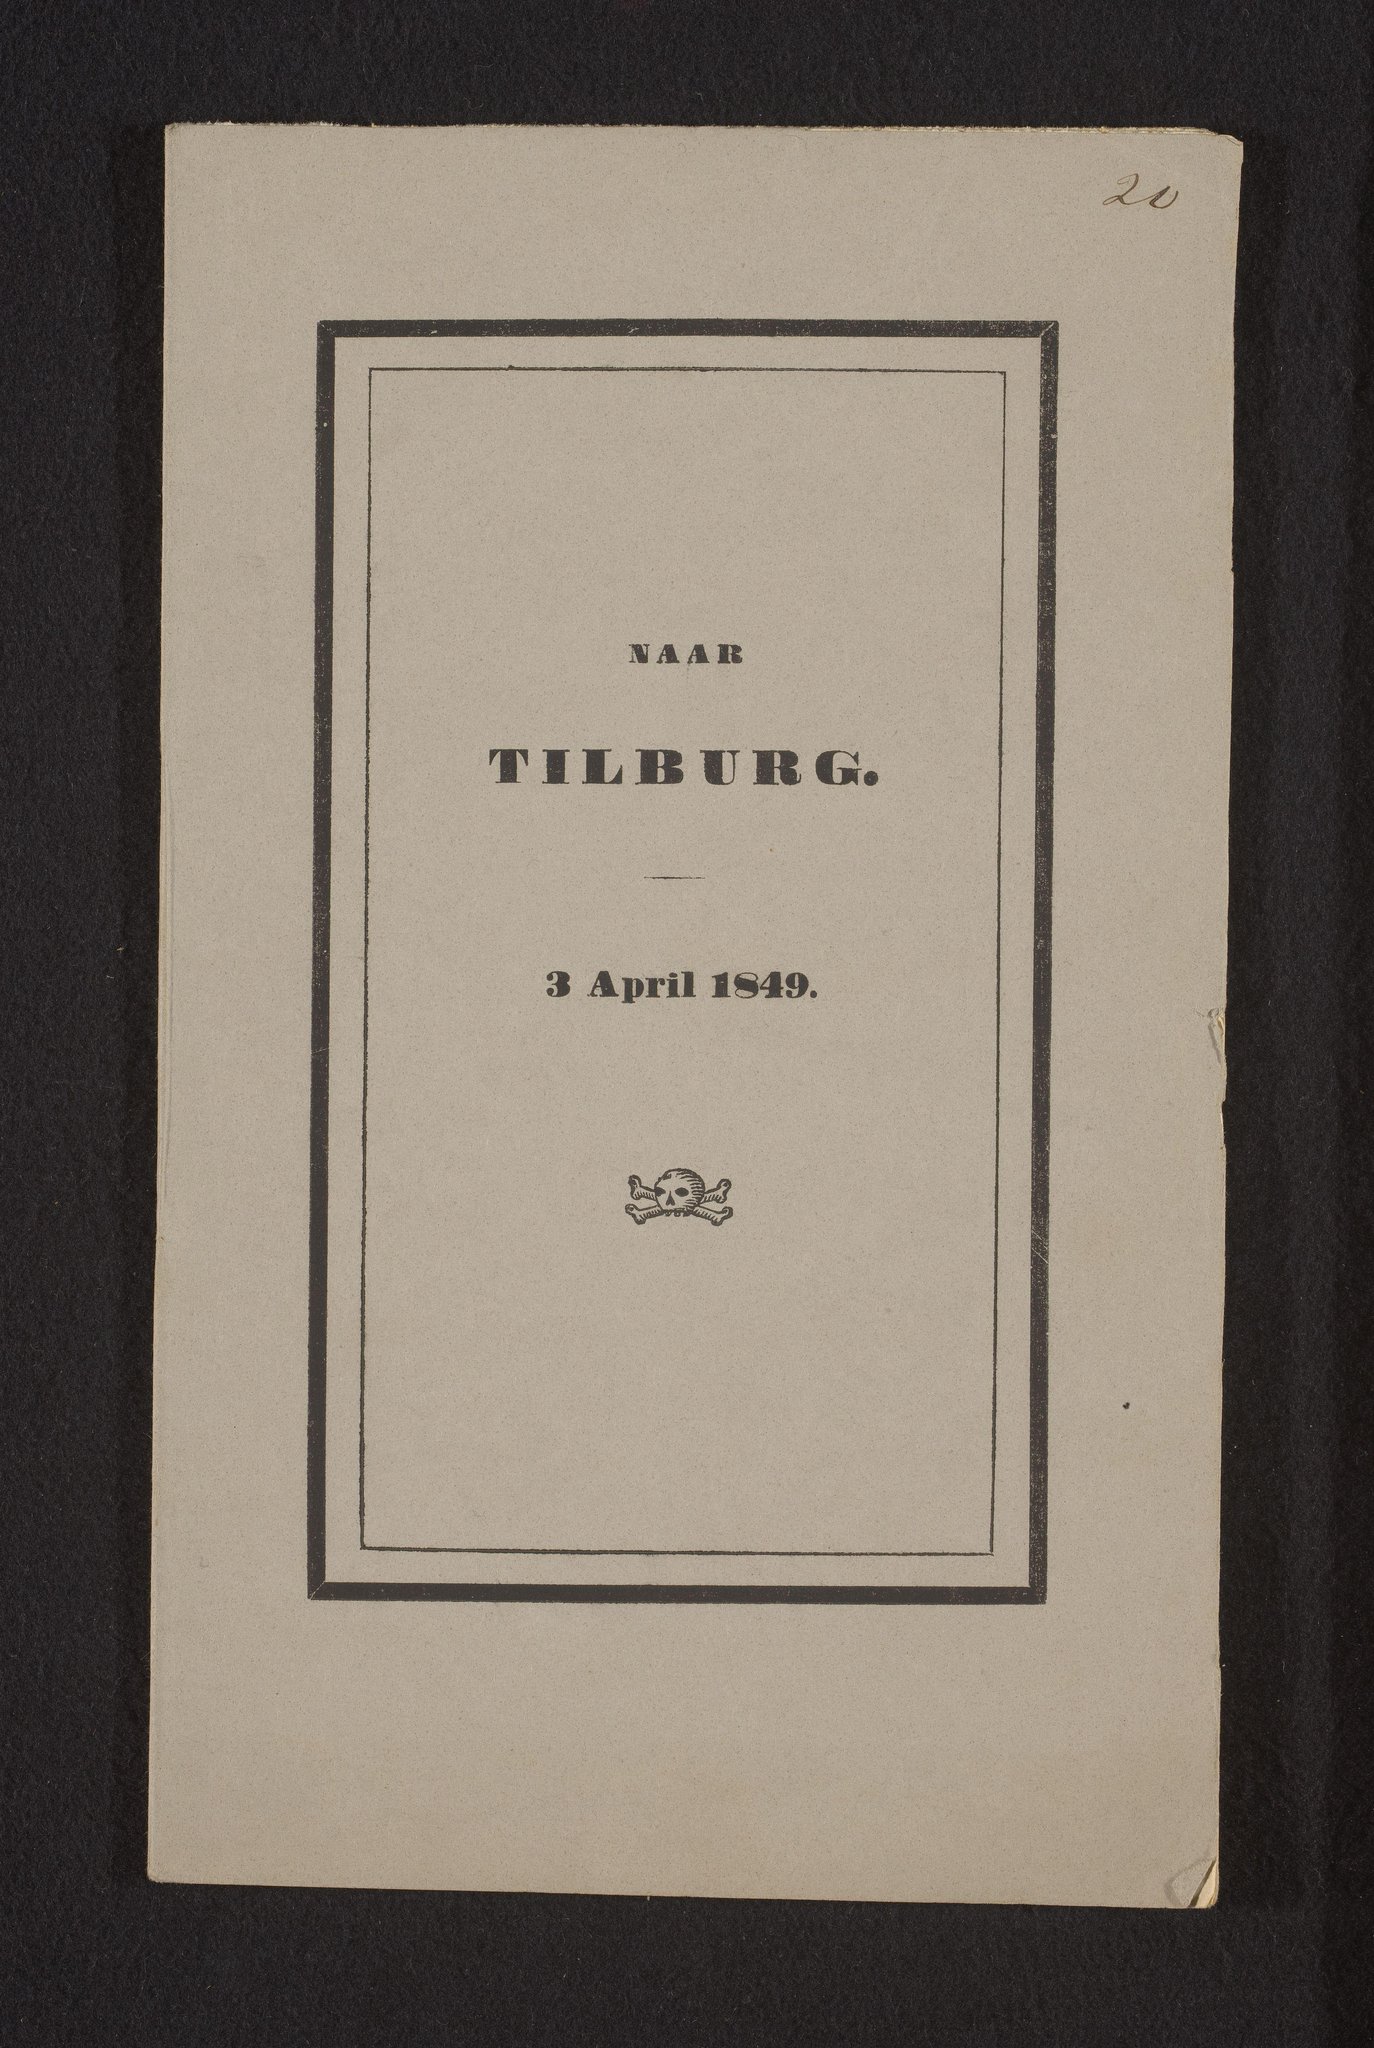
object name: brochure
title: Naar Tilburg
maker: weduwe r. stemvers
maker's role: publisher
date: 1849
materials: paper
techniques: brocade, printing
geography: amsterdam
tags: the hague, william ii of the netherlands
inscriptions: date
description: 17 genummerde pp in grijze papieren band. Gedateerd; titelp.: 1849.